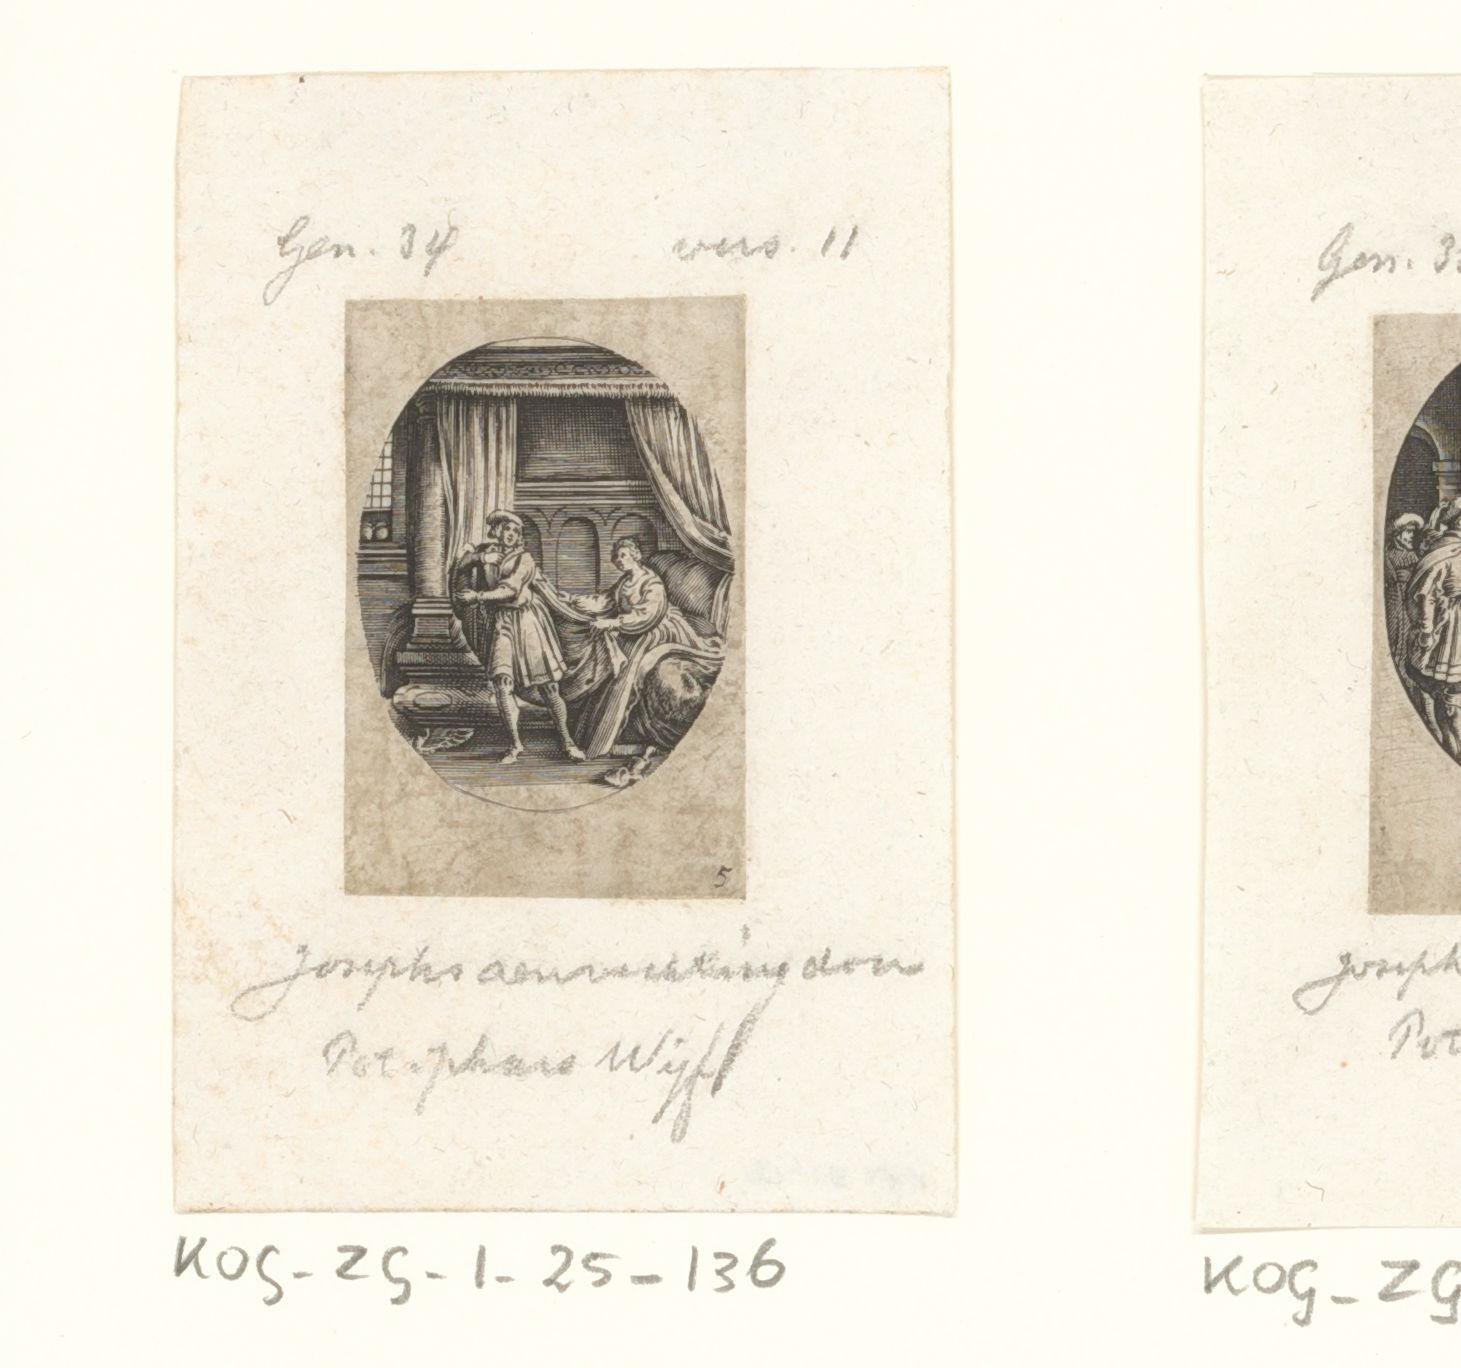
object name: print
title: Scènes uit het leven van Jozef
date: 1605-1652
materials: paper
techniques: engraving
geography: amsterdam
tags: potiphar's wife catches joseph by his robe, usually while lying in bed; joseph escapes leaving his cloak behind in her hands (possibly with a naked child lying in a crib), story of joseph (part i)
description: Een interieur met Jozef die door de vrouw van Potifar aan zijn mantel wordt getrokken. Rechtsonder genummerd: 5. Onderwerpsrubrieken binnen de Atlas Zeden en Gewoonten: Zeden en Gewoonten in Engeren Zin, De Woning, Huisraad, Zilverwerk.